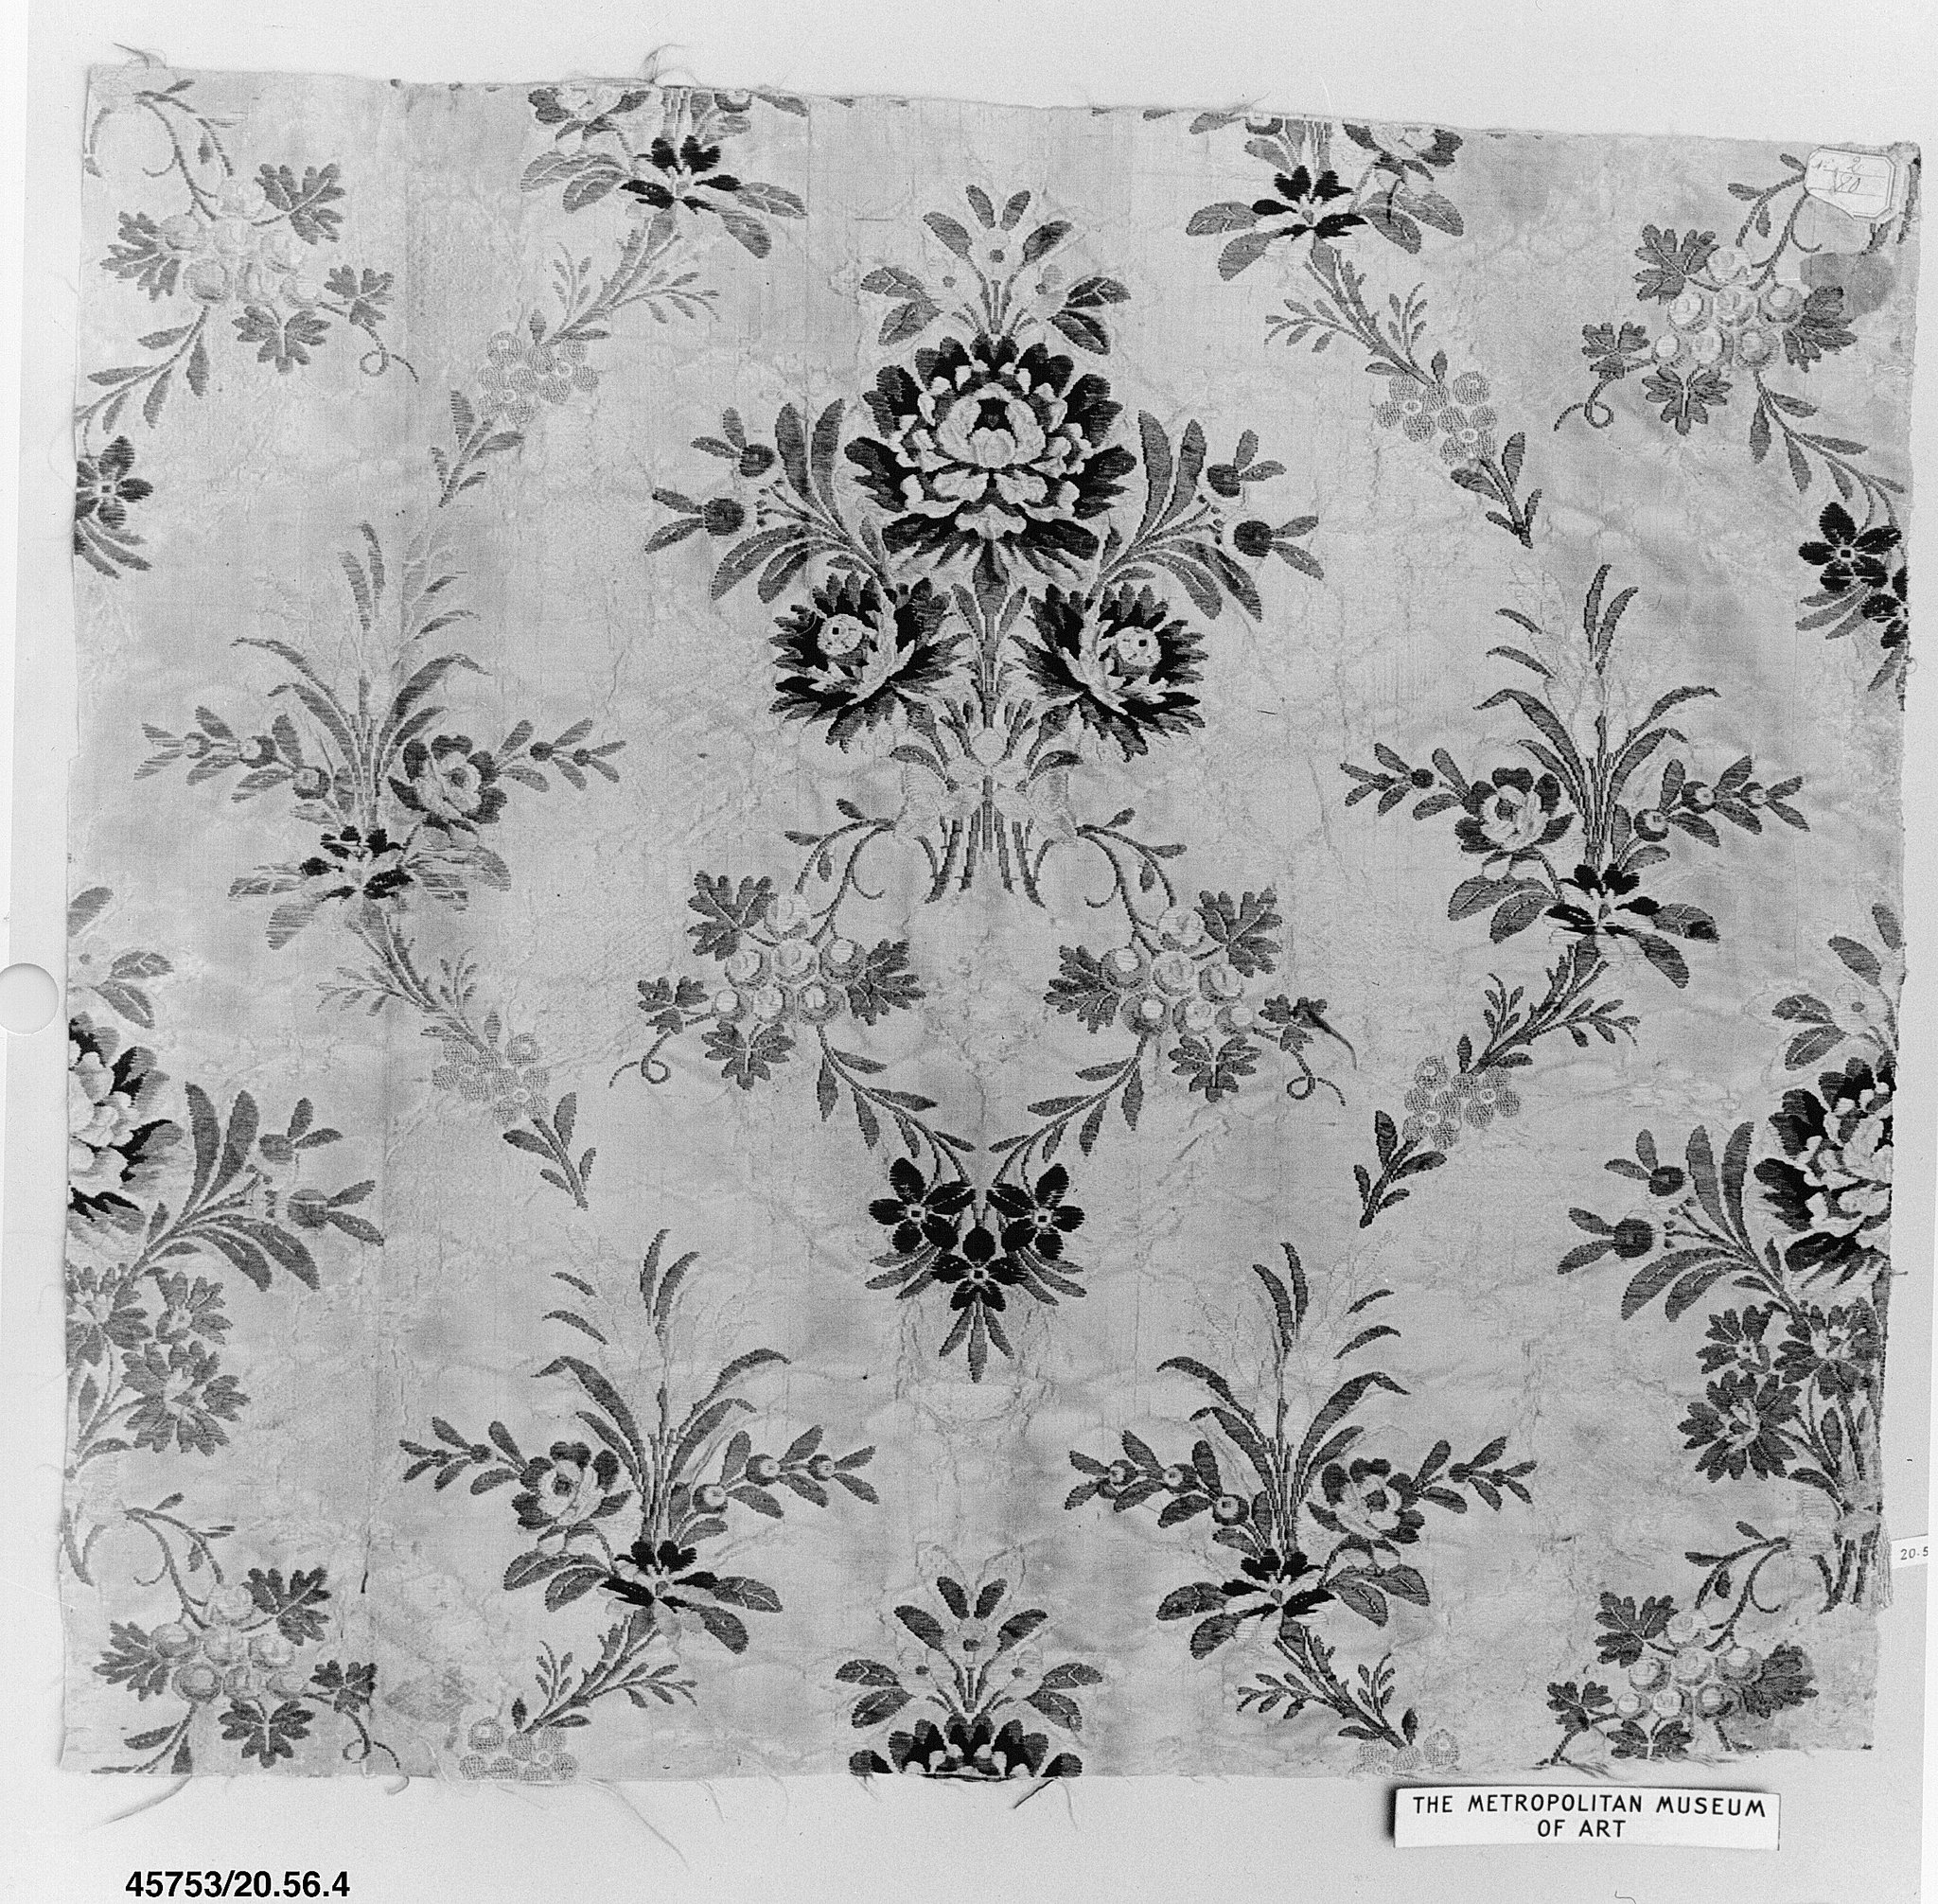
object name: piece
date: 1760-1770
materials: silk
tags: flowers,leaves